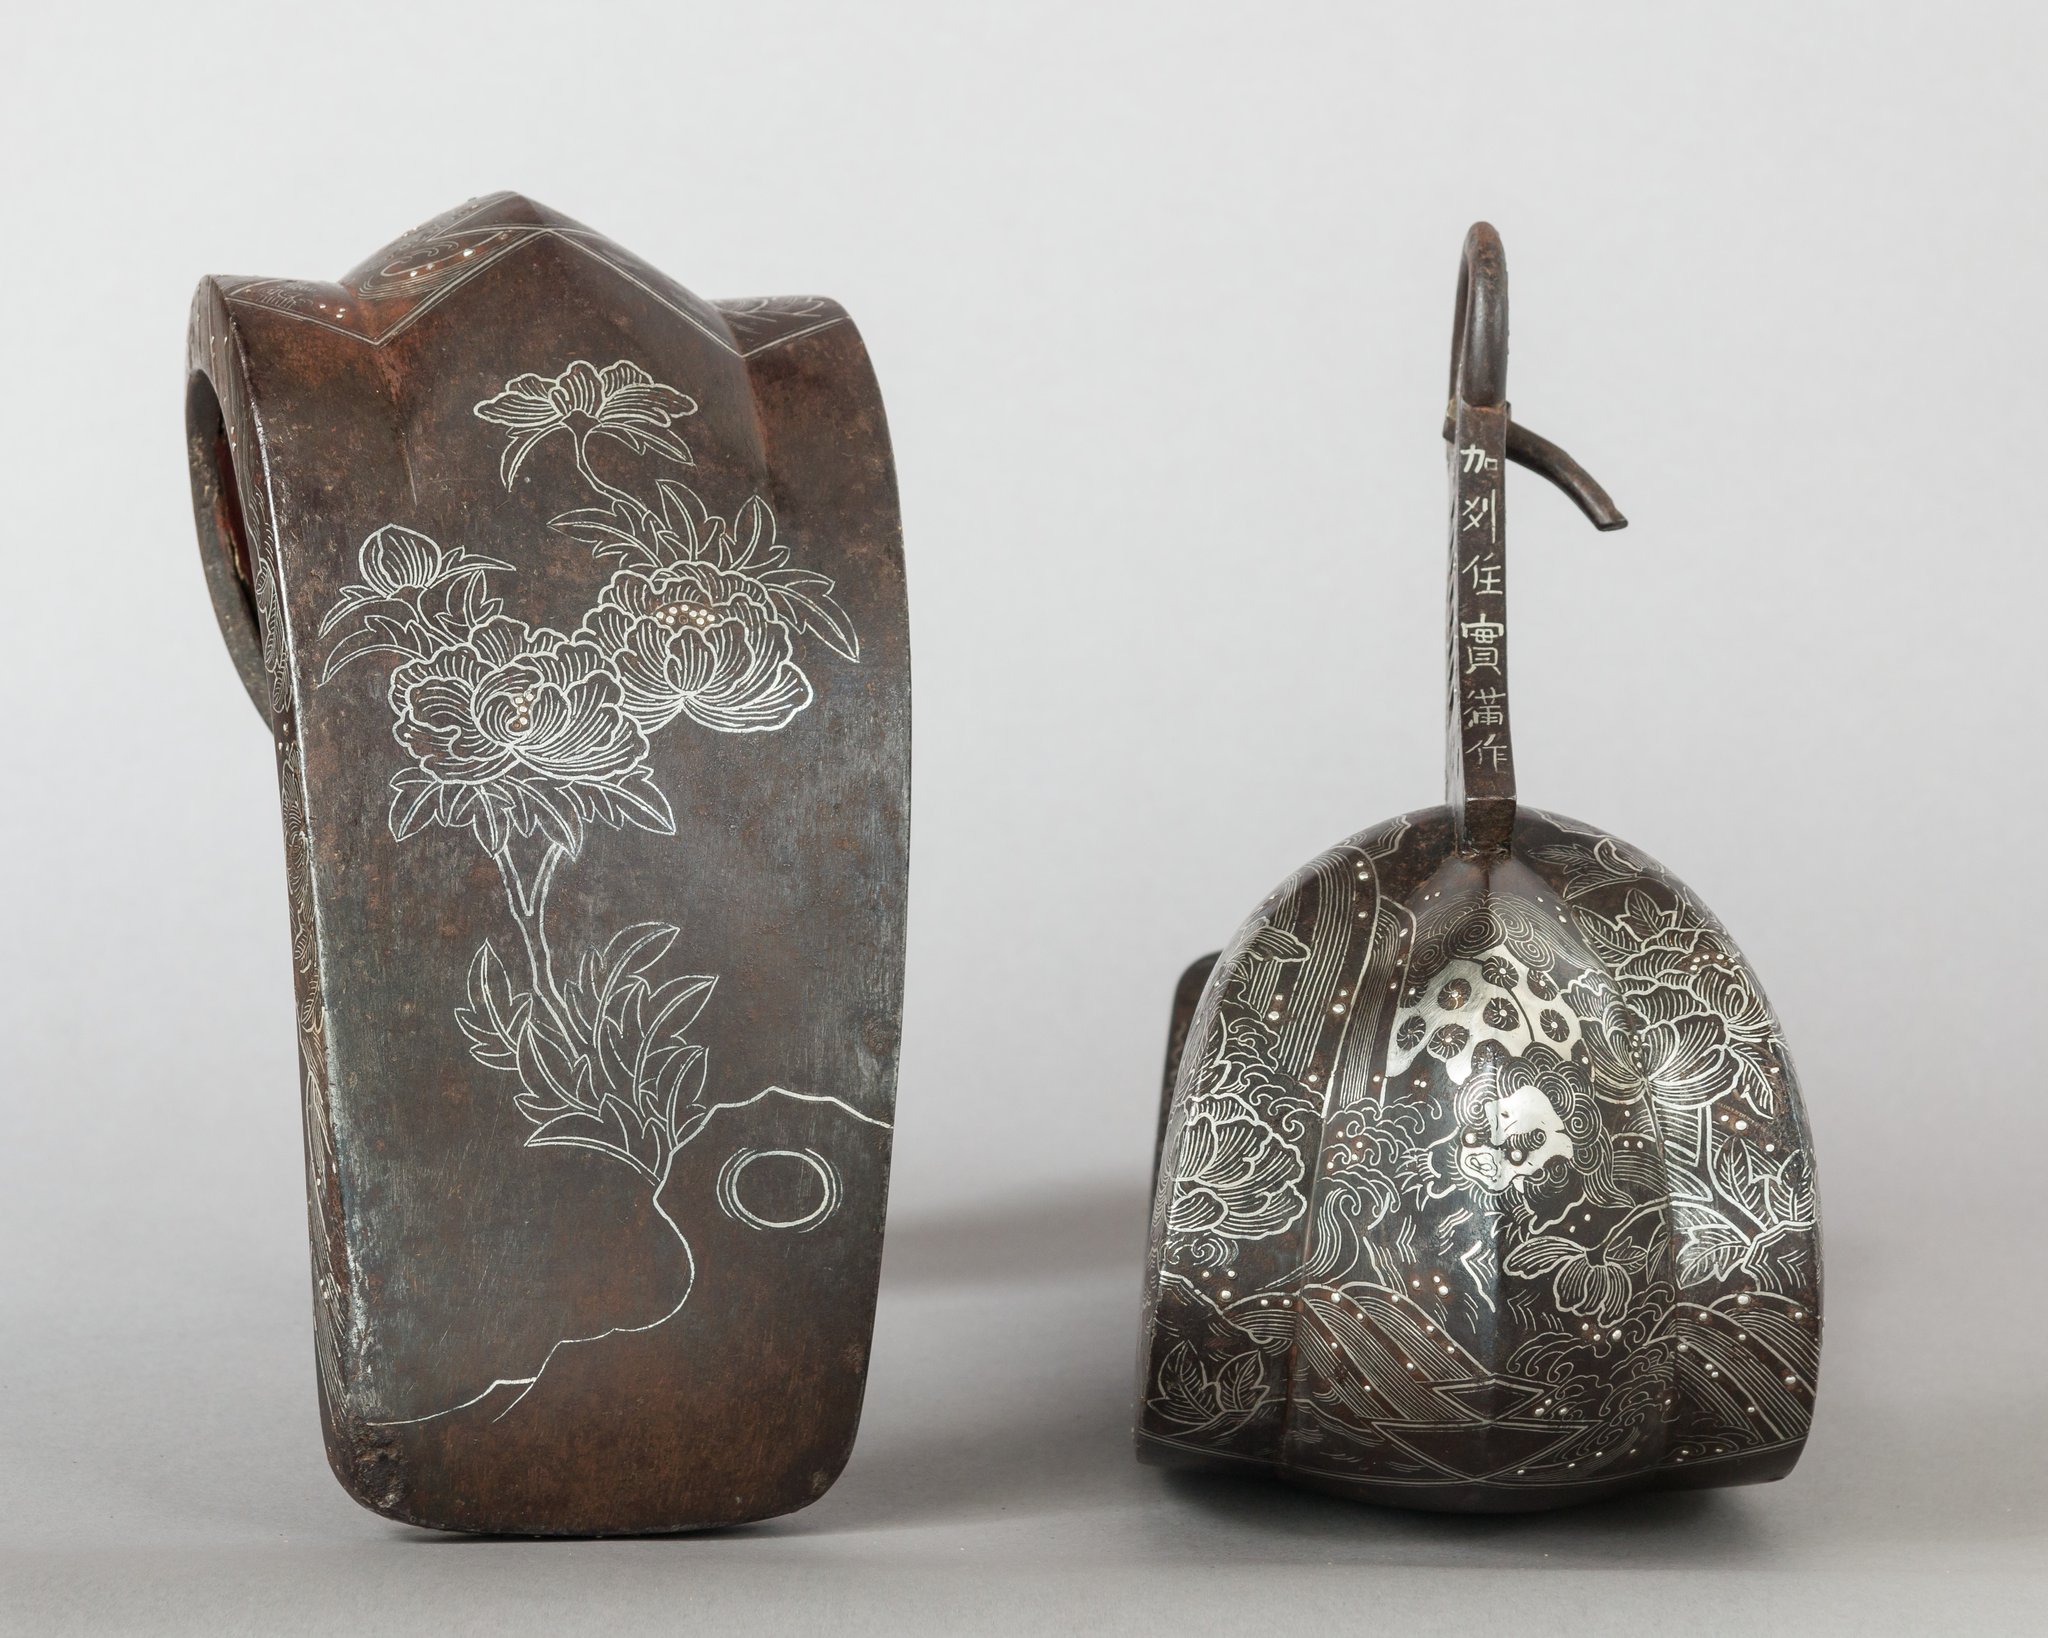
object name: pair of stirrup i abumi i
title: Pair of Stirrups (Abumi)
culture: japanese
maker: sanemitsu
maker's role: artist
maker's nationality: japanese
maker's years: 1675-1825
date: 1701-1800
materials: iron, lacquer, paper, silver, wood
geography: japan